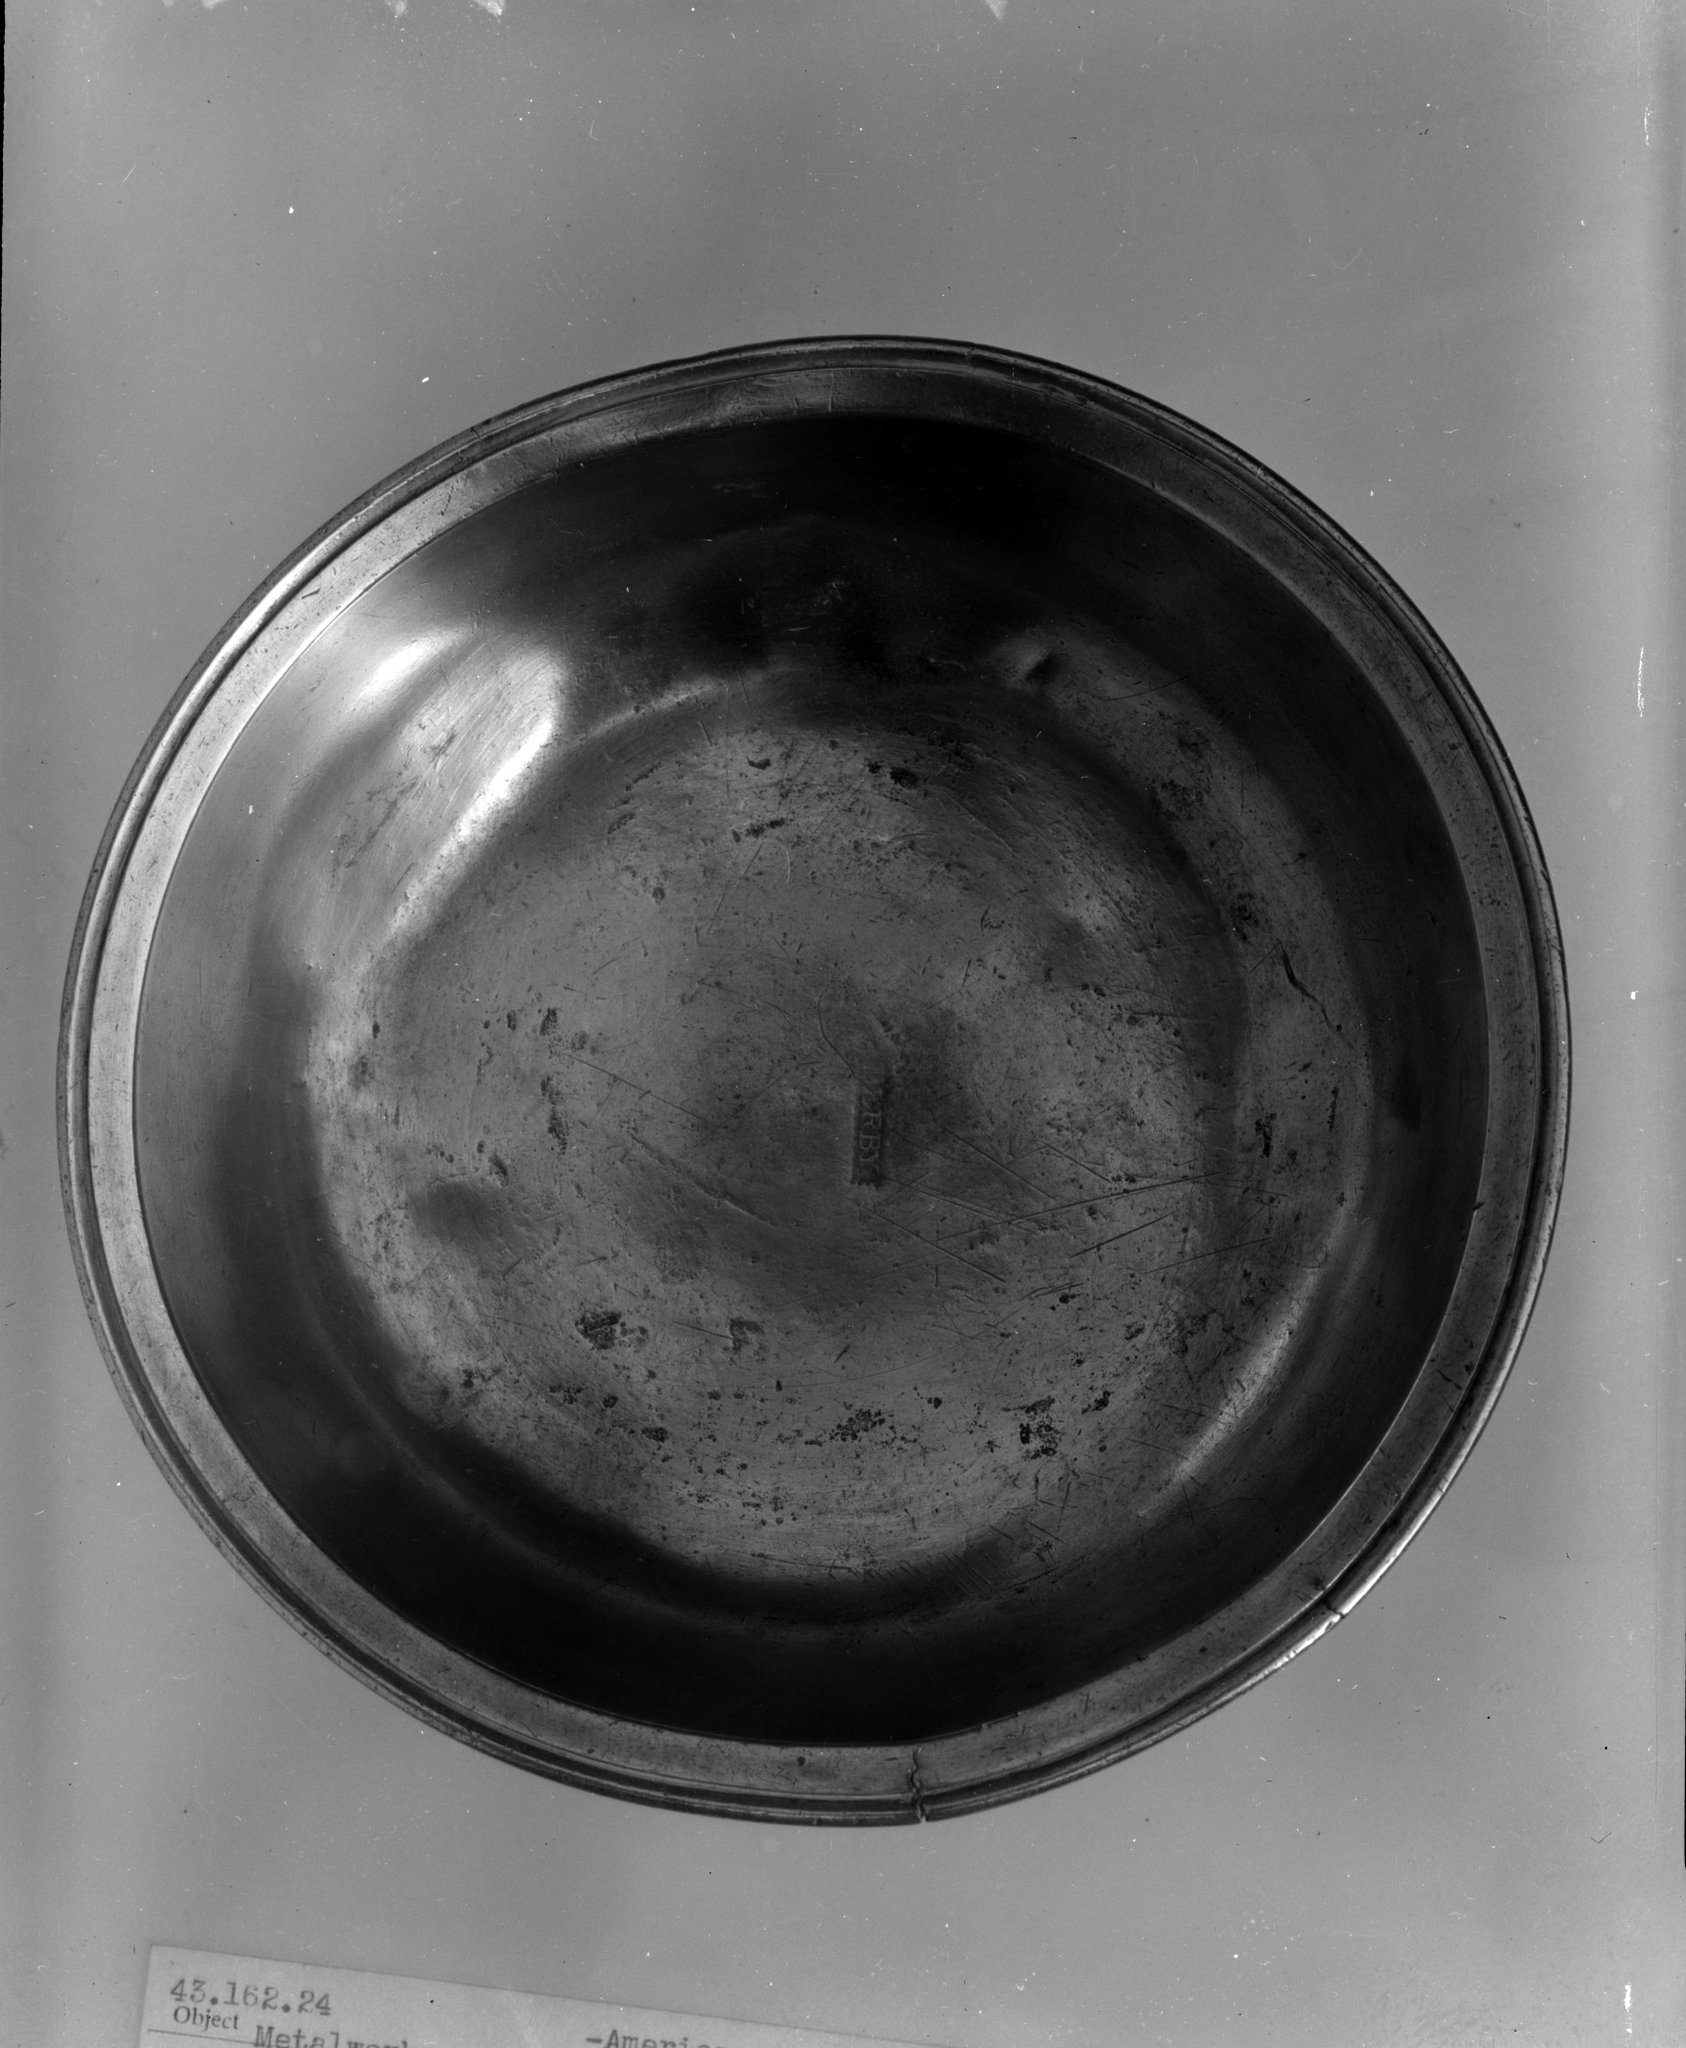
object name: basin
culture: american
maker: thomas s. derby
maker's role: maker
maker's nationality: american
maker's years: 1786-1852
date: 1822-1850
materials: pewter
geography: united states